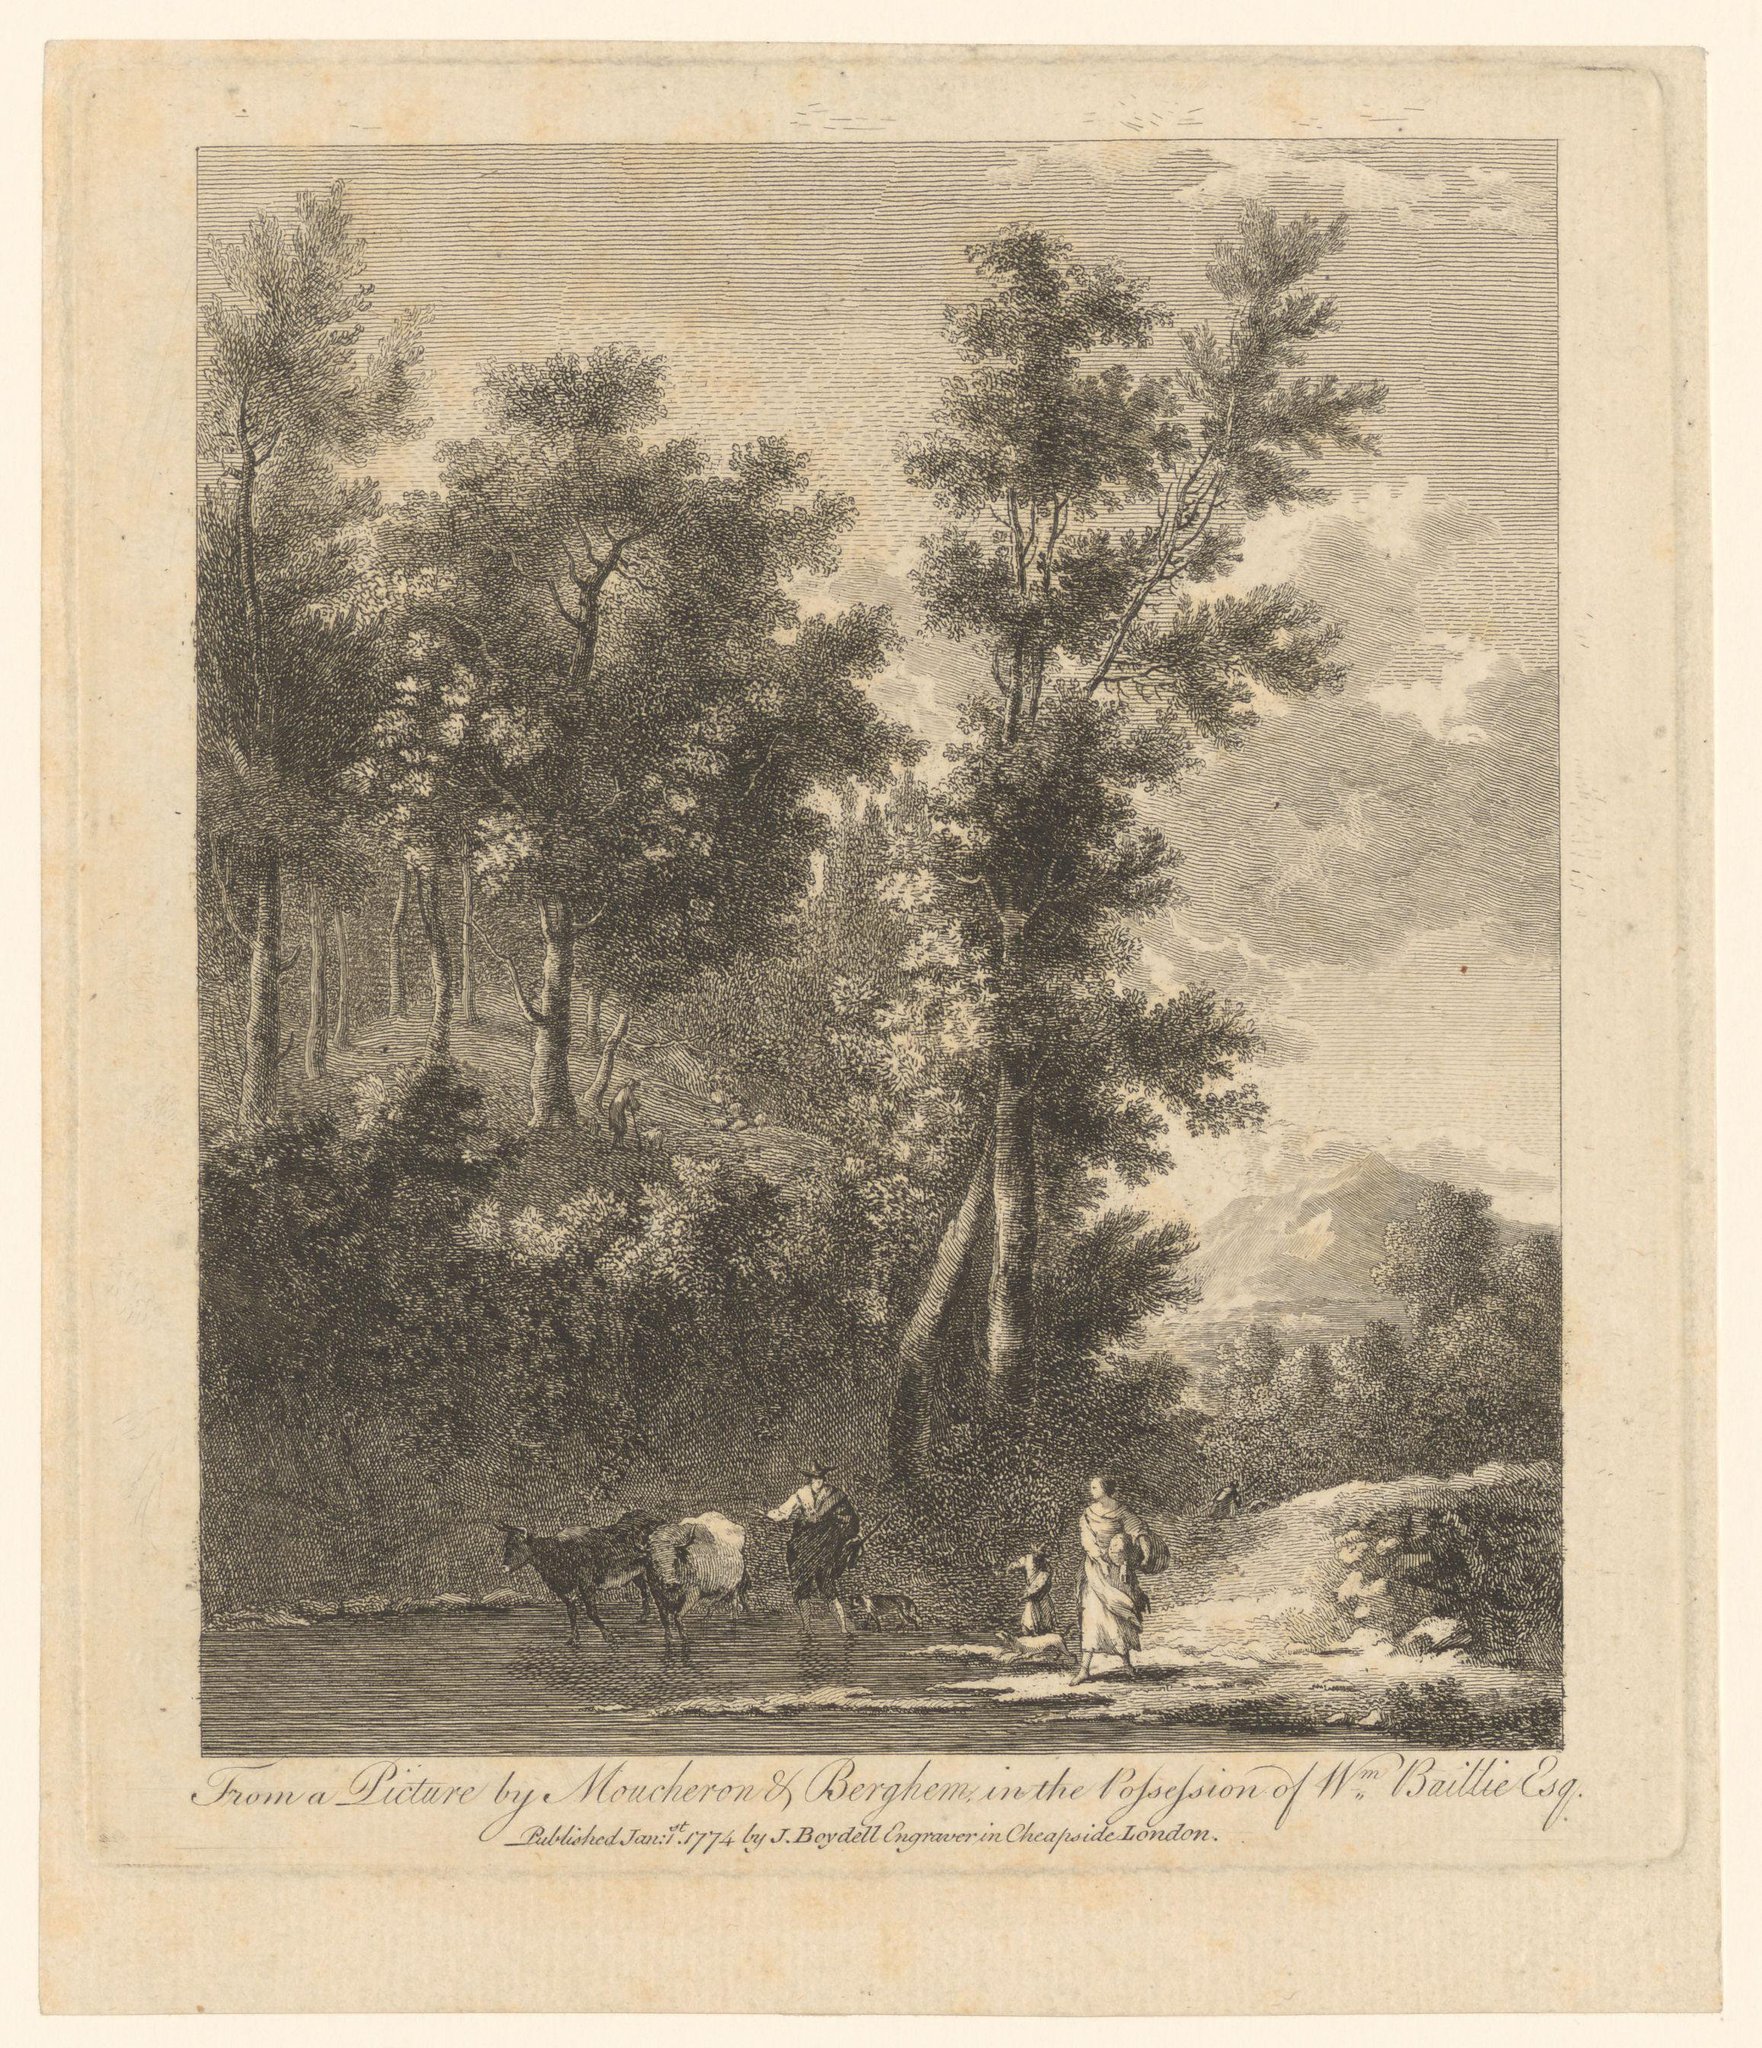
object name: print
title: Herder steekt met twee koeien een beek over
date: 1774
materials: paper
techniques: etching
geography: england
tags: herding, herdsman, herdswoman, shepherd, shepherdess, cowherd, etc., forest, wood (+ landscape with figures, staffage), brook (+ landscape with figures, staffage)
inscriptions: collector's mark: Lugt 2228